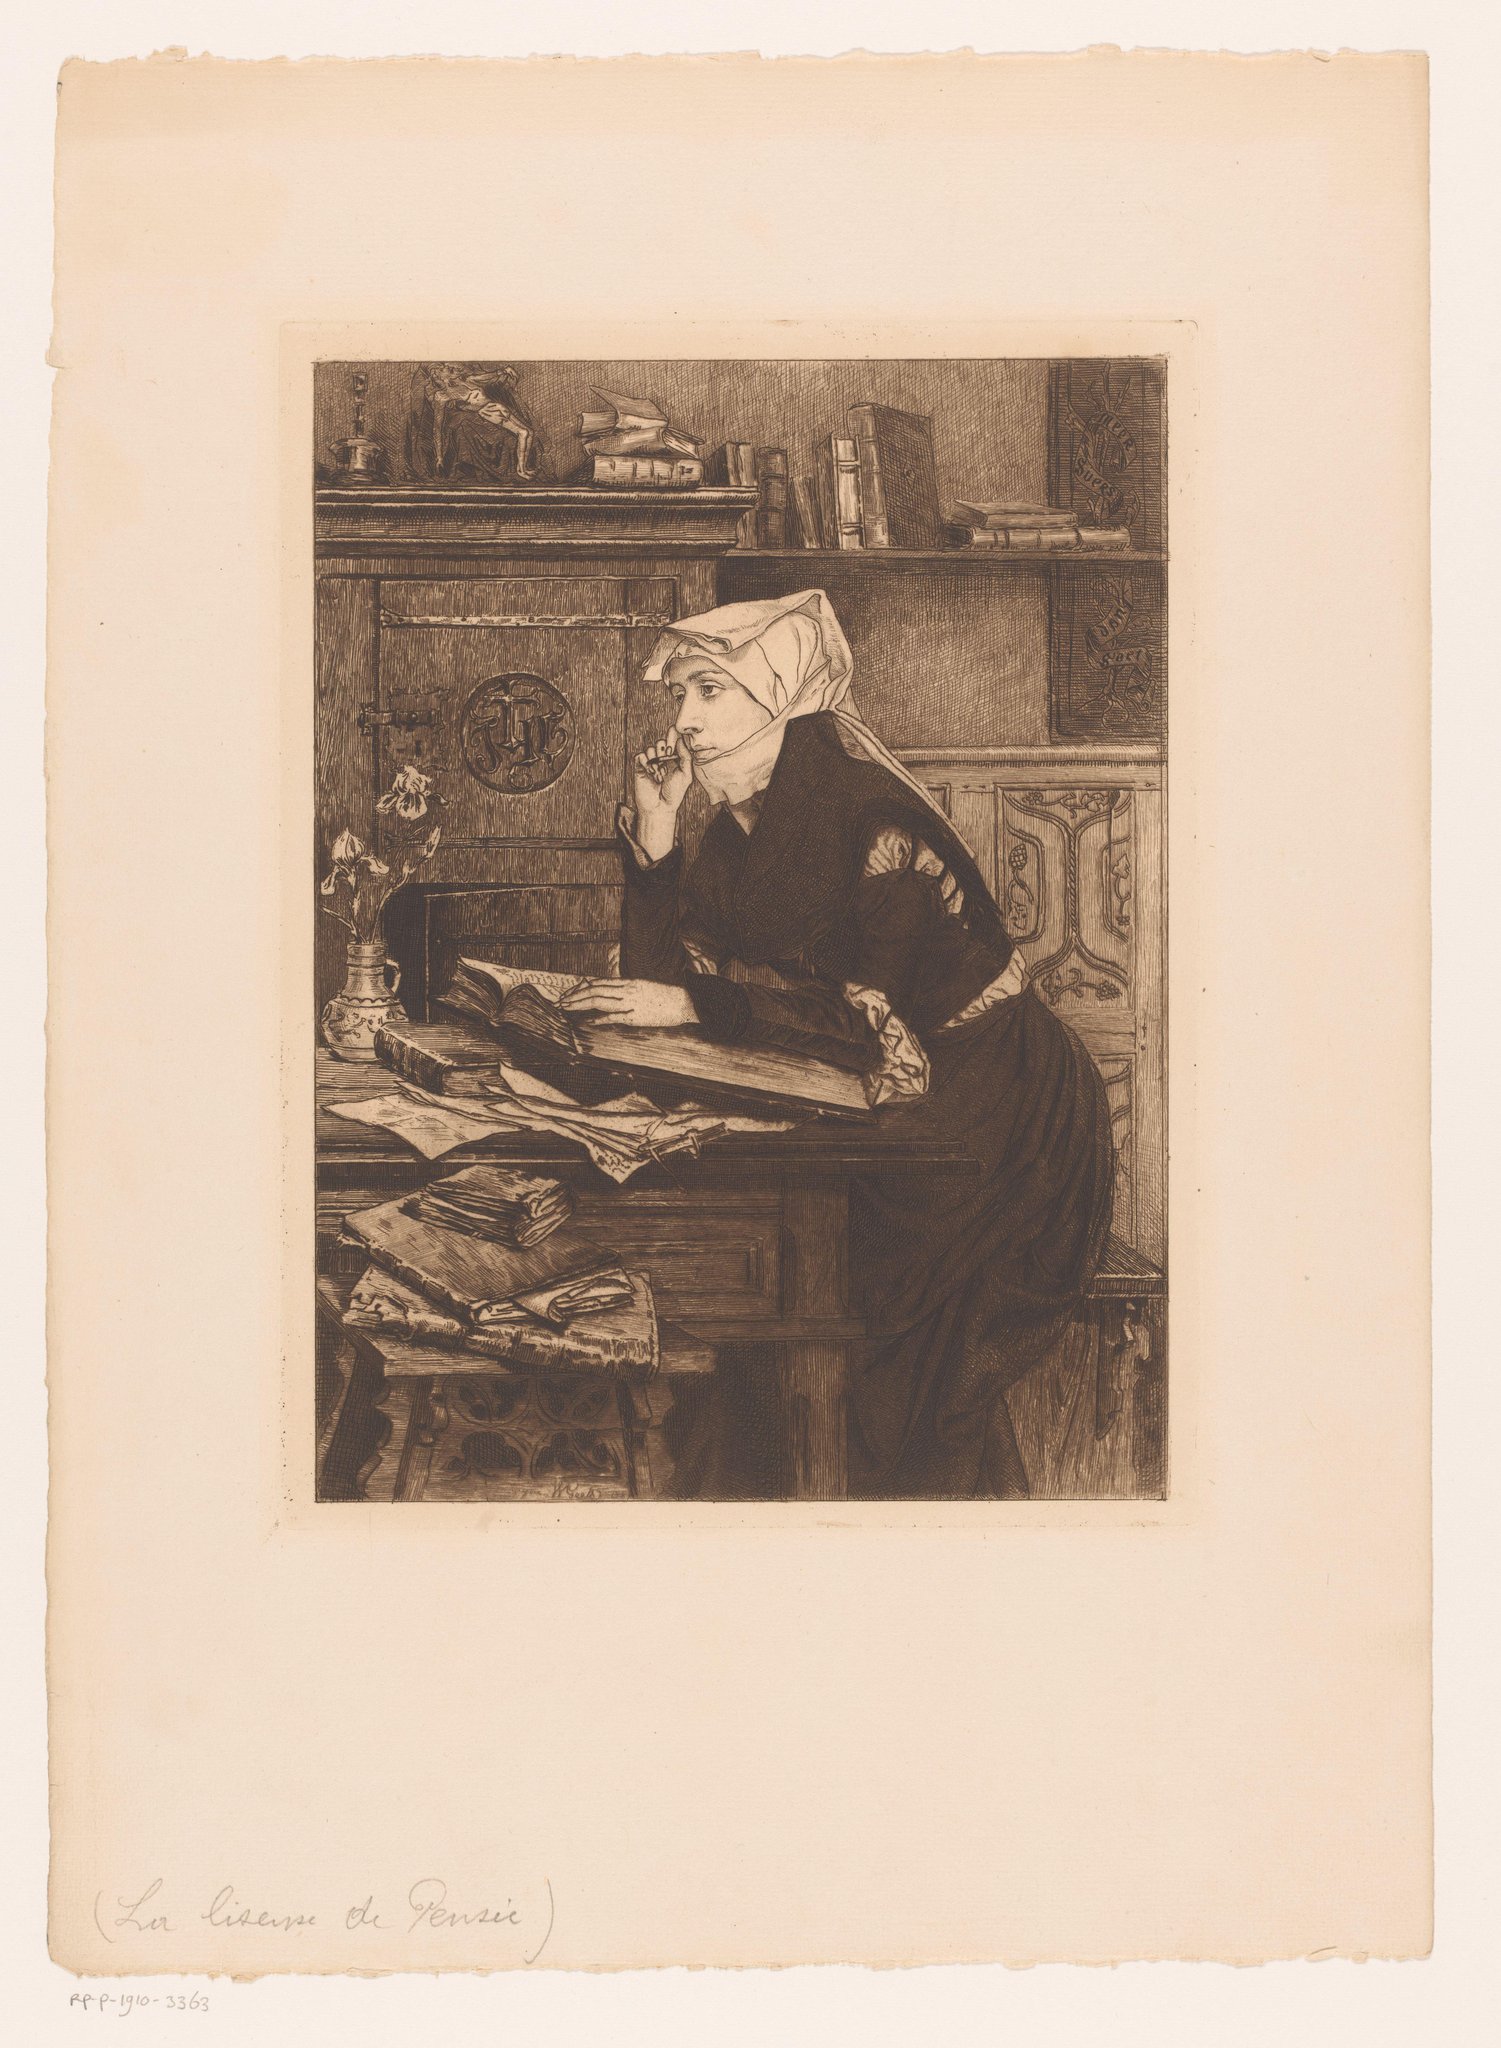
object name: print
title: Jonge vrouw nadenkend aan een schrijftafel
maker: willem geets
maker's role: print maker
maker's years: 1838-1919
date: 1887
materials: paper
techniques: etching, intaglio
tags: writing-table, writing-desk, adolescent, young woman, maiden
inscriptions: collector's mark: Lugt 2228